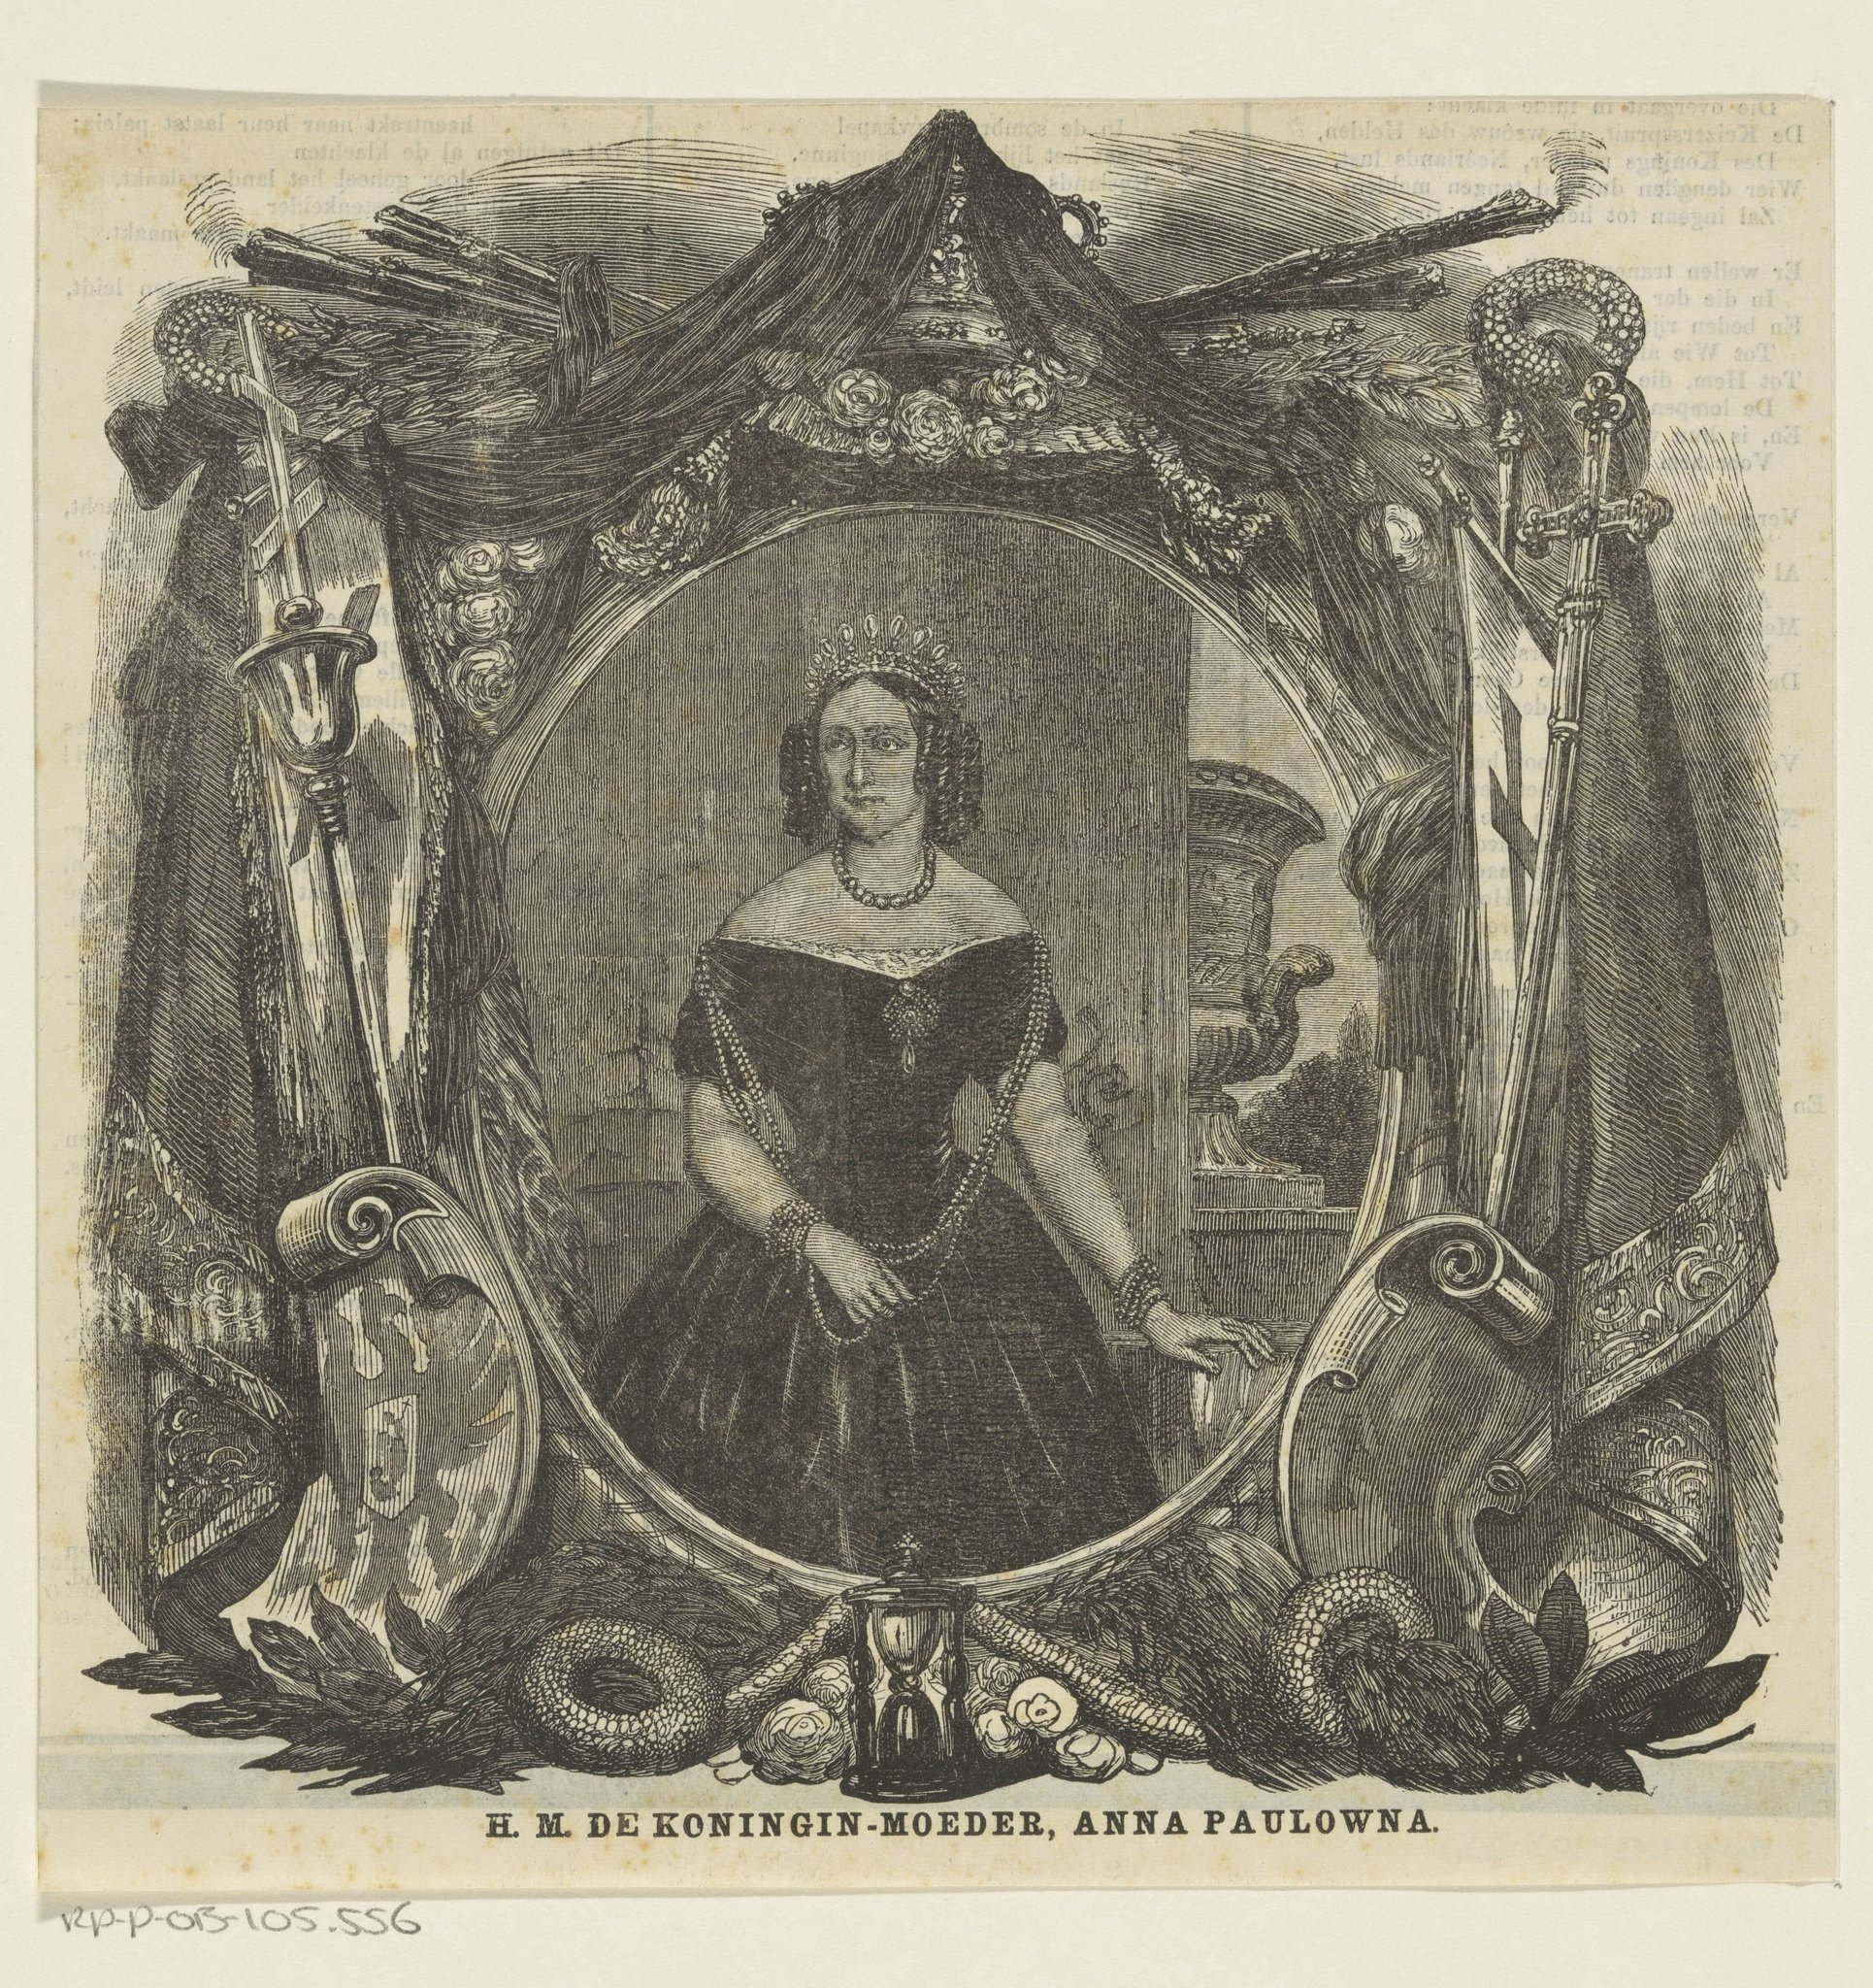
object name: print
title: Portret van Anna Paulowna Romanowa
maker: Anonymous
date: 1865-1949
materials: paper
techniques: letterpress printing, engraving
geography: netherlands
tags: the hague, anna paulowna romanowa, william ii of the netherlands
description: Portret van Anna Paulowna in een ovaal. Daar omheen meerdere allegorische objecten, waaronder haar wapen, het wapen van Willem II en een zandloper.